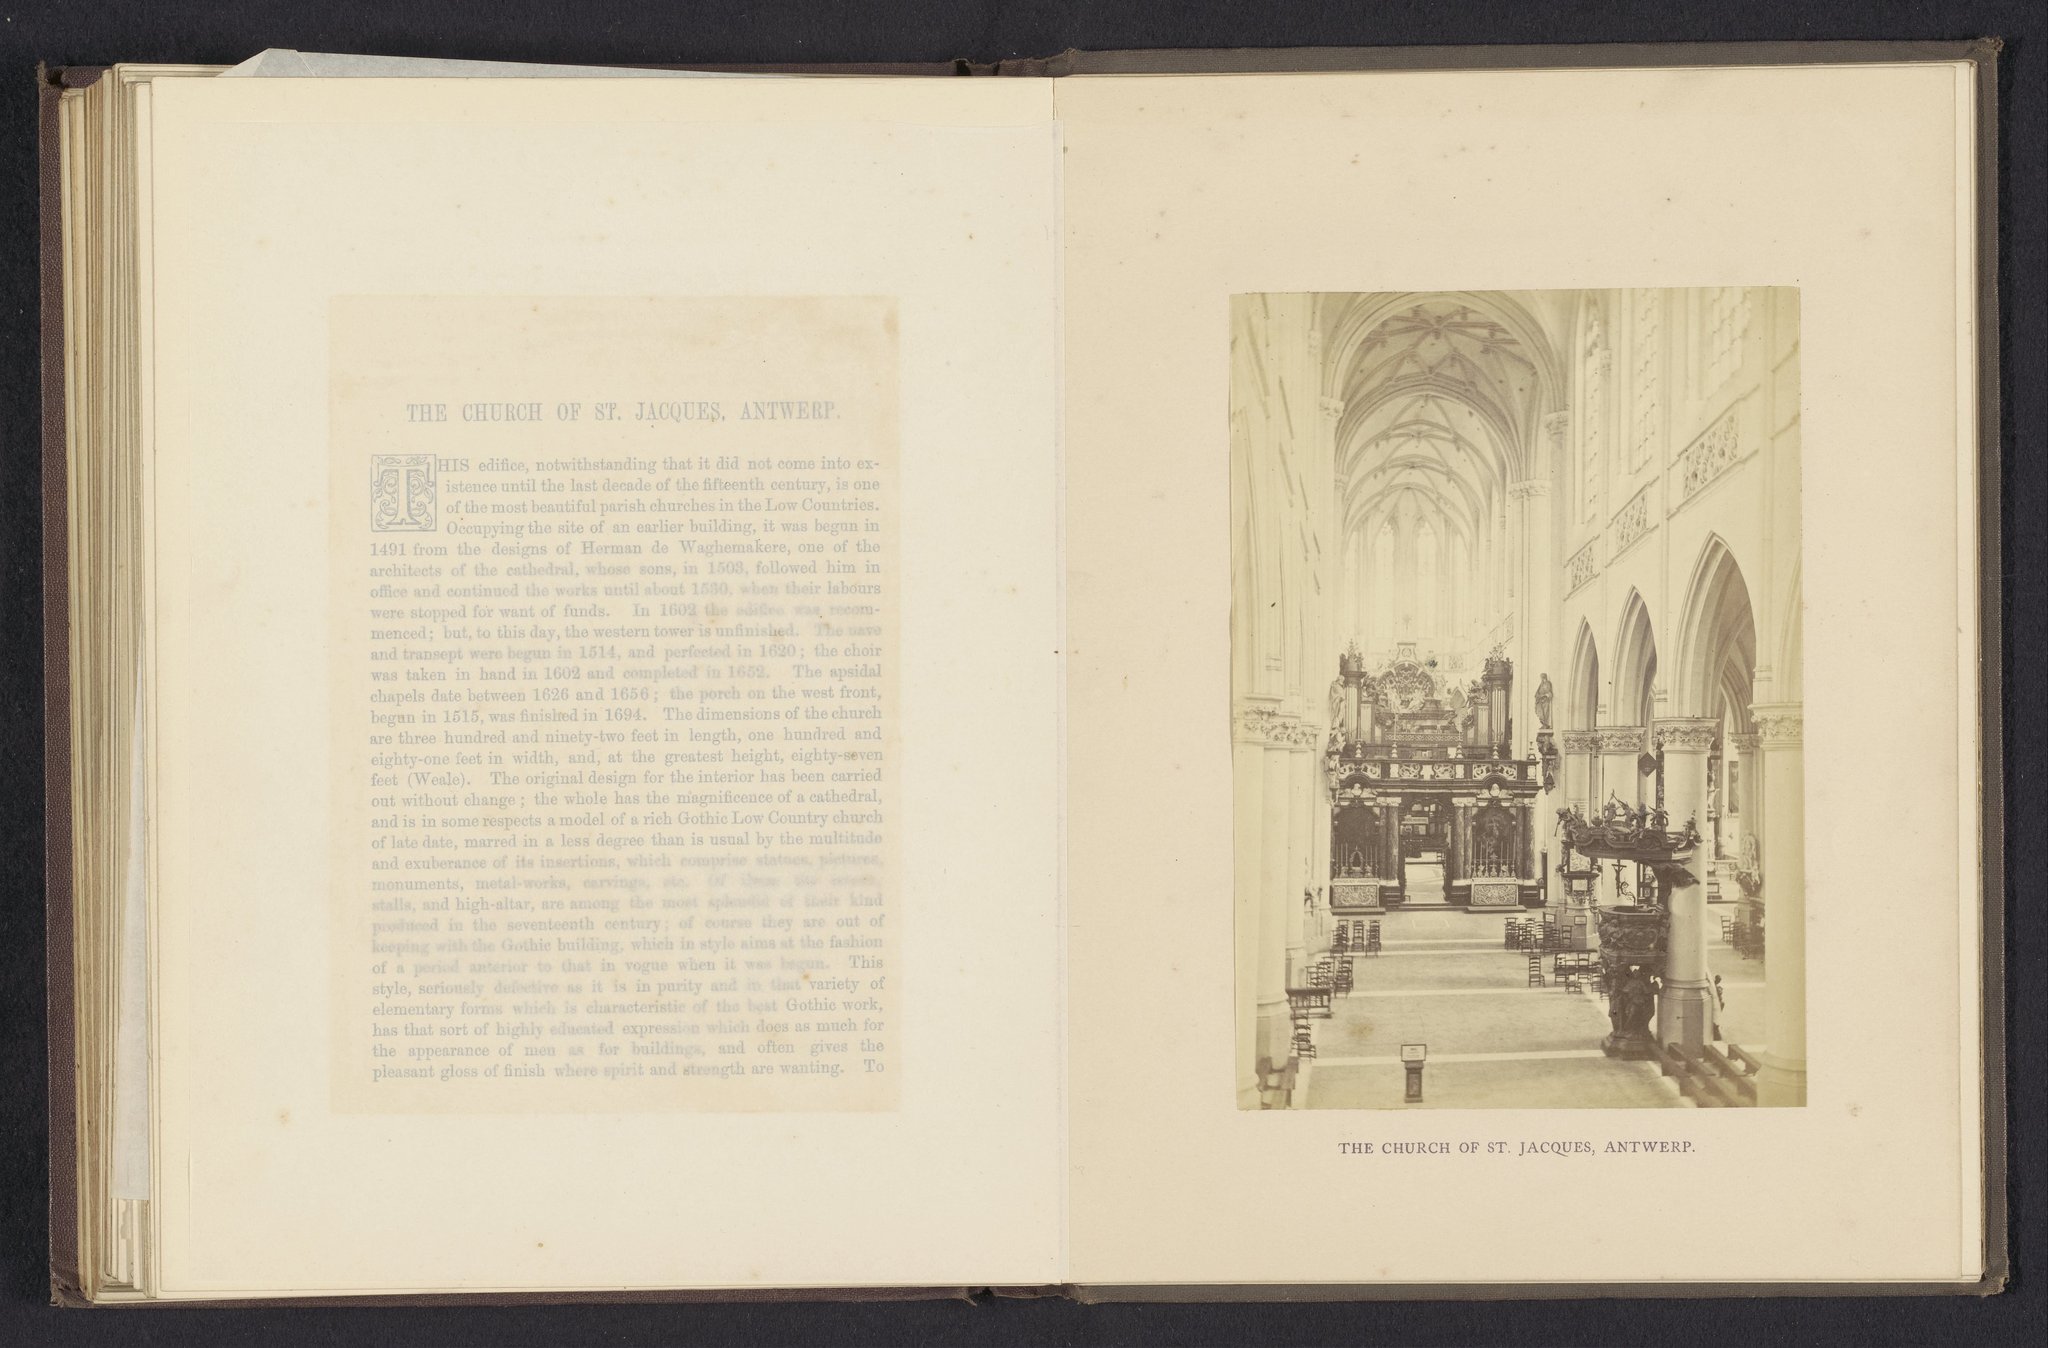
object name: photograph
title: The church of St. Jacques, Antwerp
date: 1856-1866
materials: photographic support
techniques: albumen print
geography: antwerpen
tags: parts of church interior: aisle, interior of church